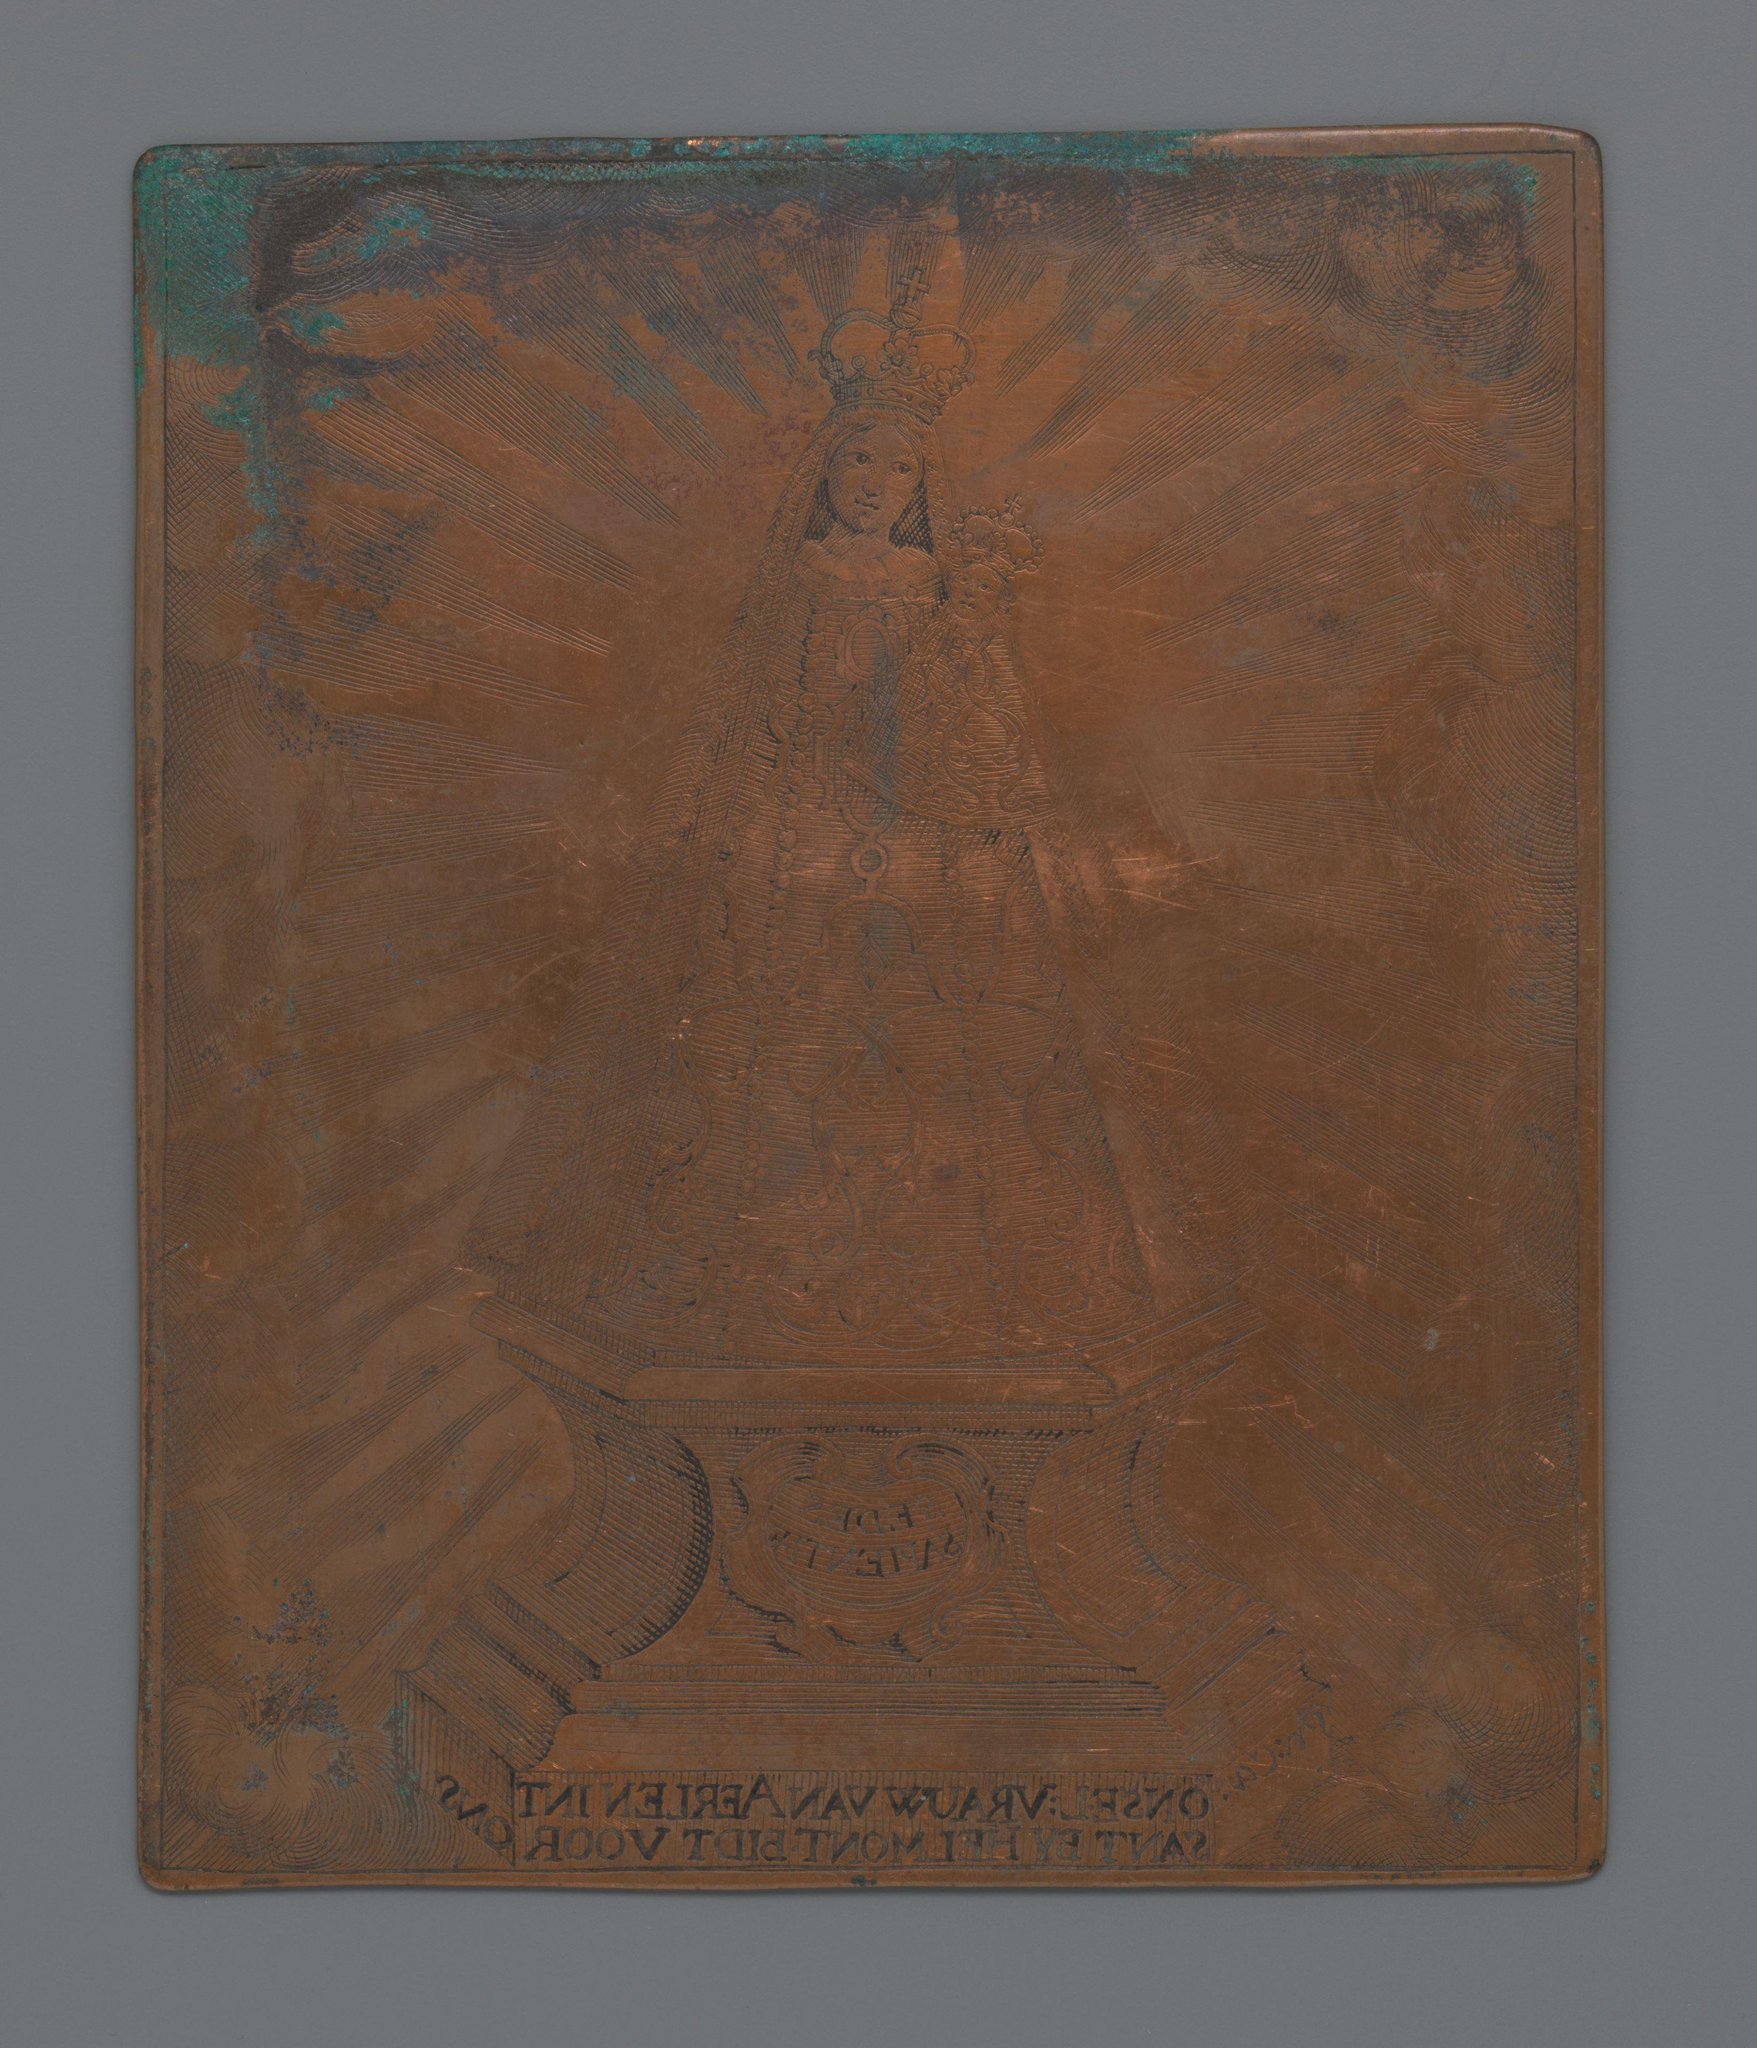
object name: copper plate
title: Koperplaat met Maria met kind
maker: philips galle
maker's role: print maker, publisher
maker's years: 1537-1612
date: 1650-1720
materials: copper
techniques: engraving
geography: antwerp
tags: mary standing (or half-length), the christ-child on her arm (christ-child to mary's left)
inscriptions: signature: ‘Ph. Ga.’, : ‘Onsel vrauw van aerlen int sant bv helmont bidt voor ons’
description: De platen (RP-D-2014-9-1 t/m 35) zijn vrijwel allemaal vervaardigd door anonieme graveurs werkend voor de Antwerpse uitgevers Cornelis Galle, Frans Huberti (Huybrechts), Theodor van Merlen II en Michel Bunel. Vermoedelijk zijn ze uiteindelijk beland in één fonds, wellicht dat van Michel Bunel (1670-1739) en warden sindsdien bij elkaar bewaard. Afwijkend is de grote prent van Henry Verbruggen met een weergave van de Preekstoel uit de St. Gudule-kerk te Brussel. Twee prenten zijn verpakt in een oude afdruk van de prent, zoals te doen gebruikelijk in uitgeverijen (vergl. oude platen in Museum Plantijn Moretus, Antwerpen). Van 8 platen heeft de vorige eigenaar afdrukken laten maken op modern papier.